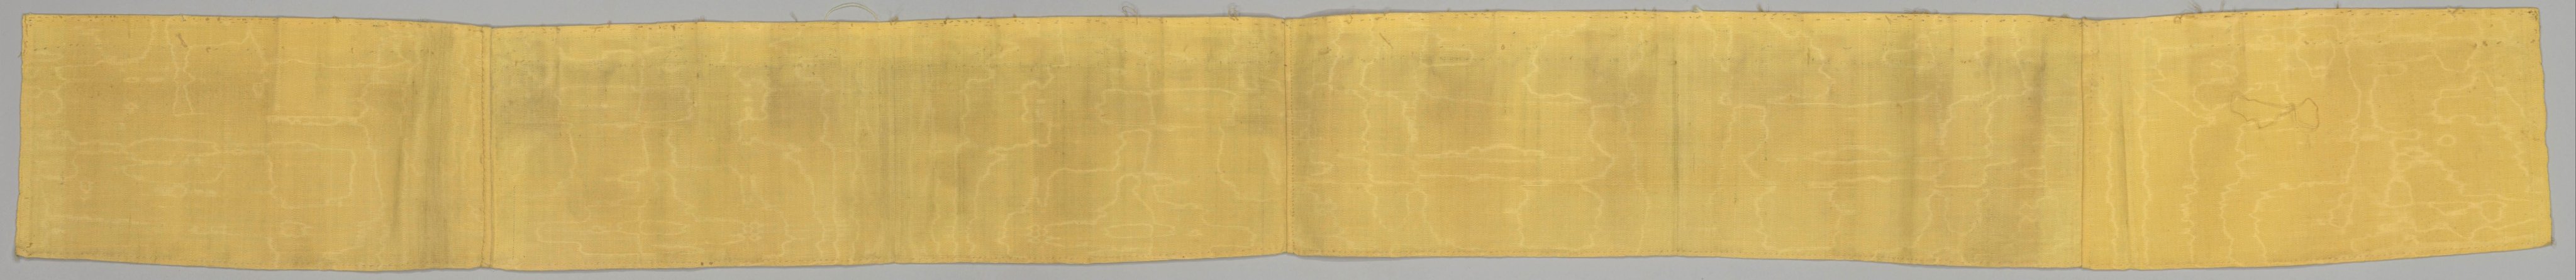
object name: bed covering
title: Fragment van een bedgarnituur van gele gewaterde wol met groen passement en afhangende klosjes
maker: Anonymous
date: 1795-1815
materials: wool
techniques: moire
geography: northern netherlands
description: Fragment van een bedgarnituur van gele gewaterde wol, omboord met groen passement met een geel motief en met een groen en geel boordsel met afhangende klosjes die met gele en groene zijde zijn omwonden.